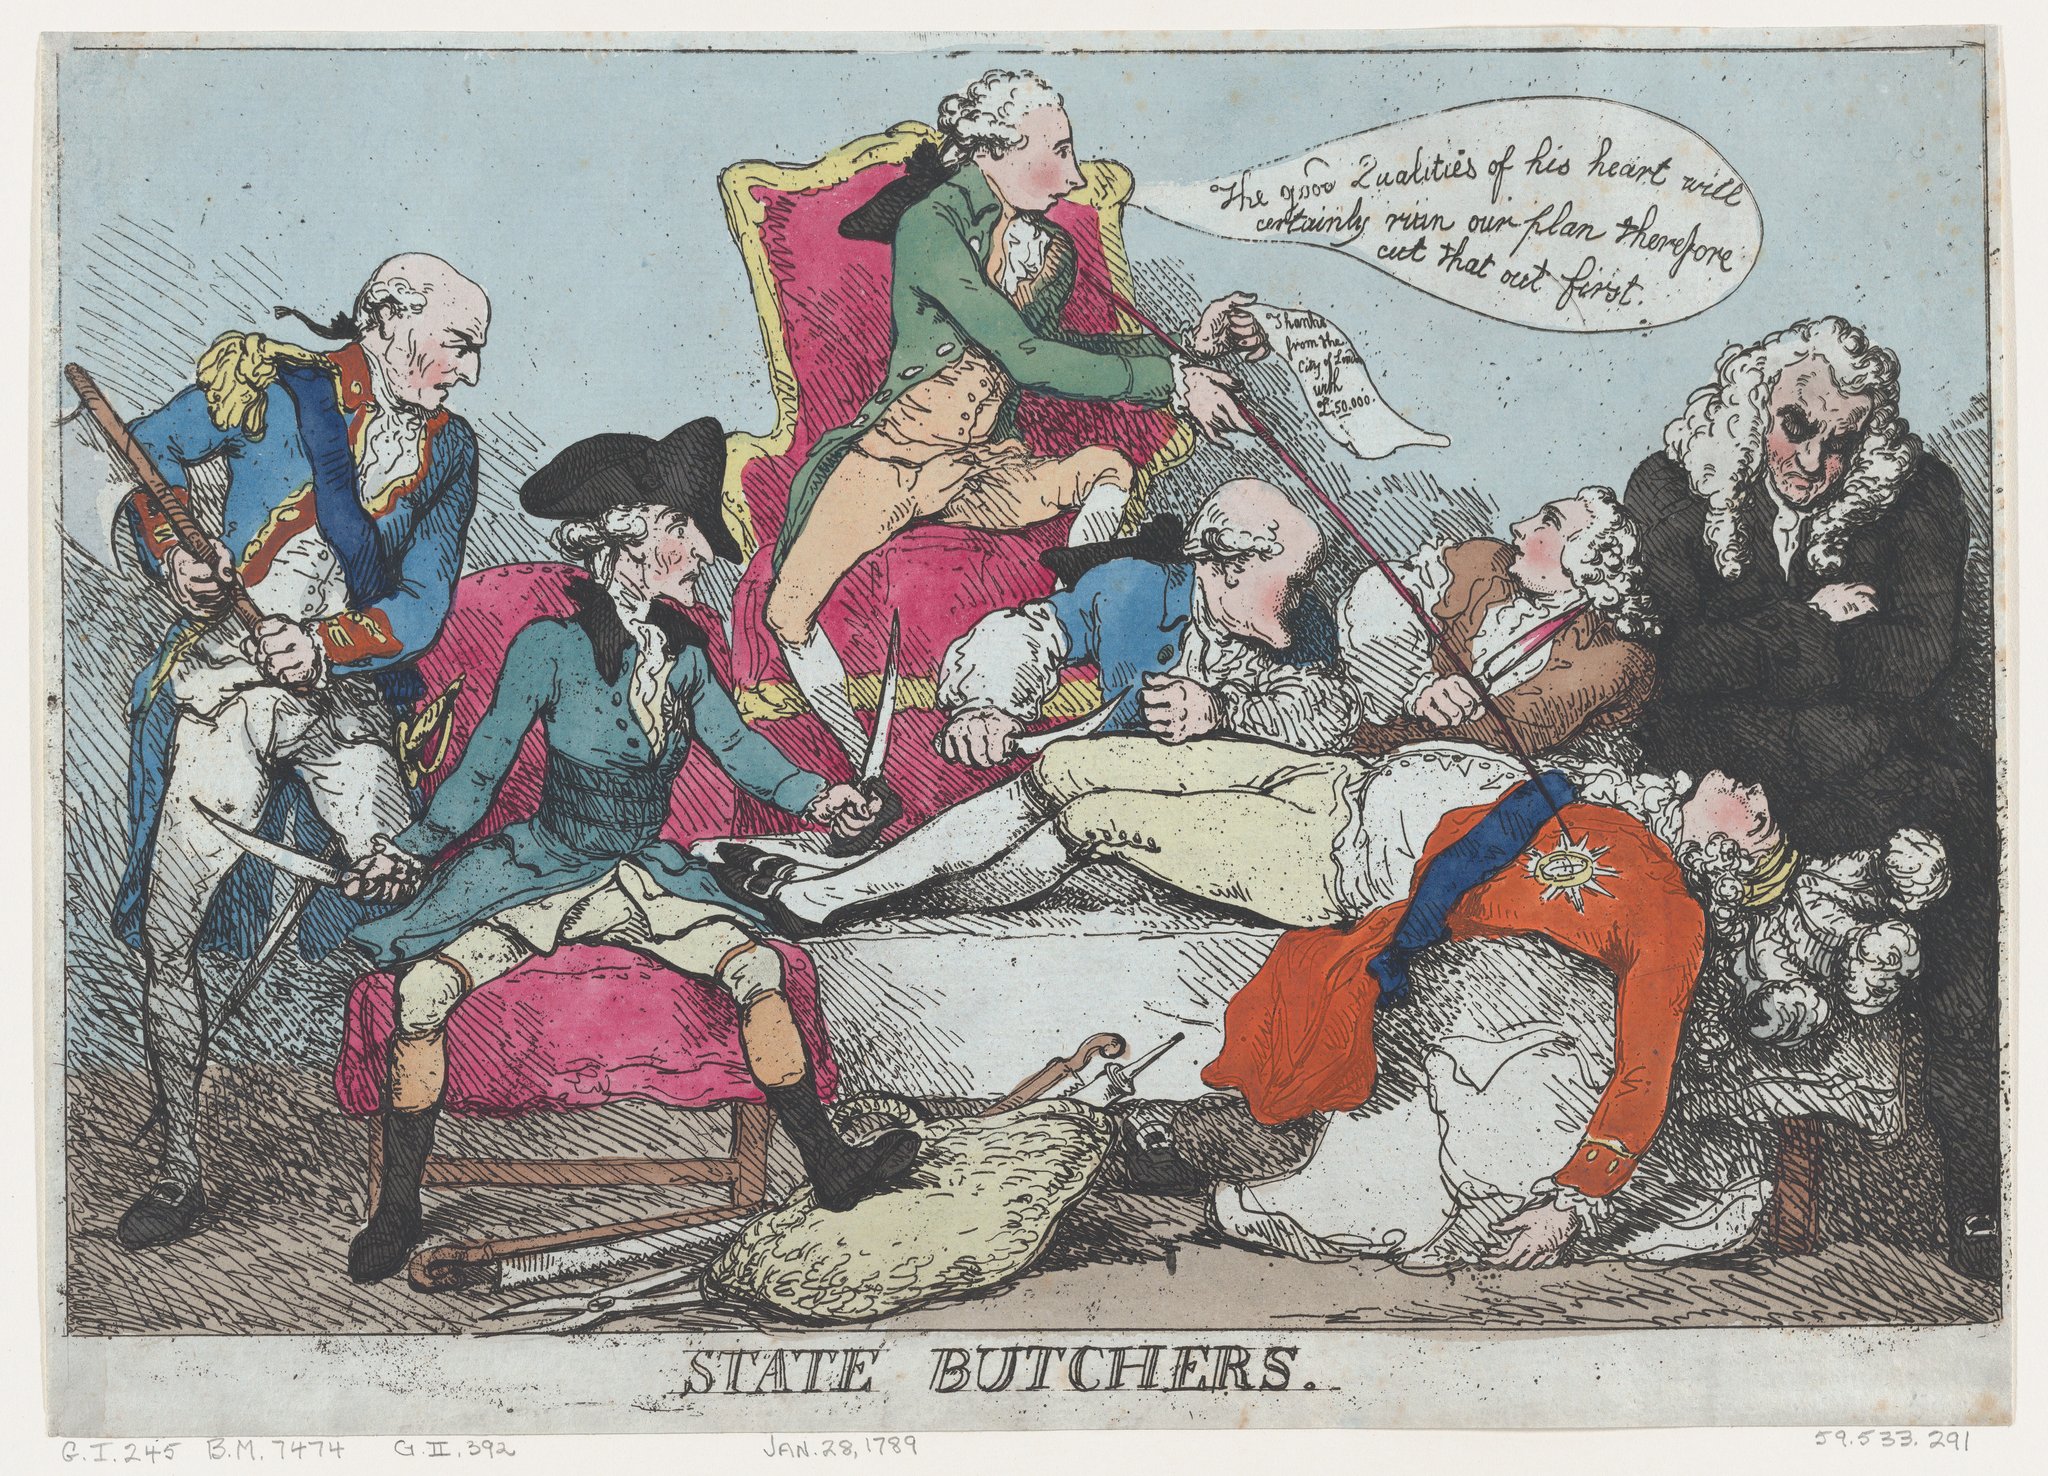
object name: print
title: State Butchers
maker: thomas rowlandson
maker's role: artist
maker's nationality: british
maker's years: 1757-1827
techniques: etching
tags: satire,men